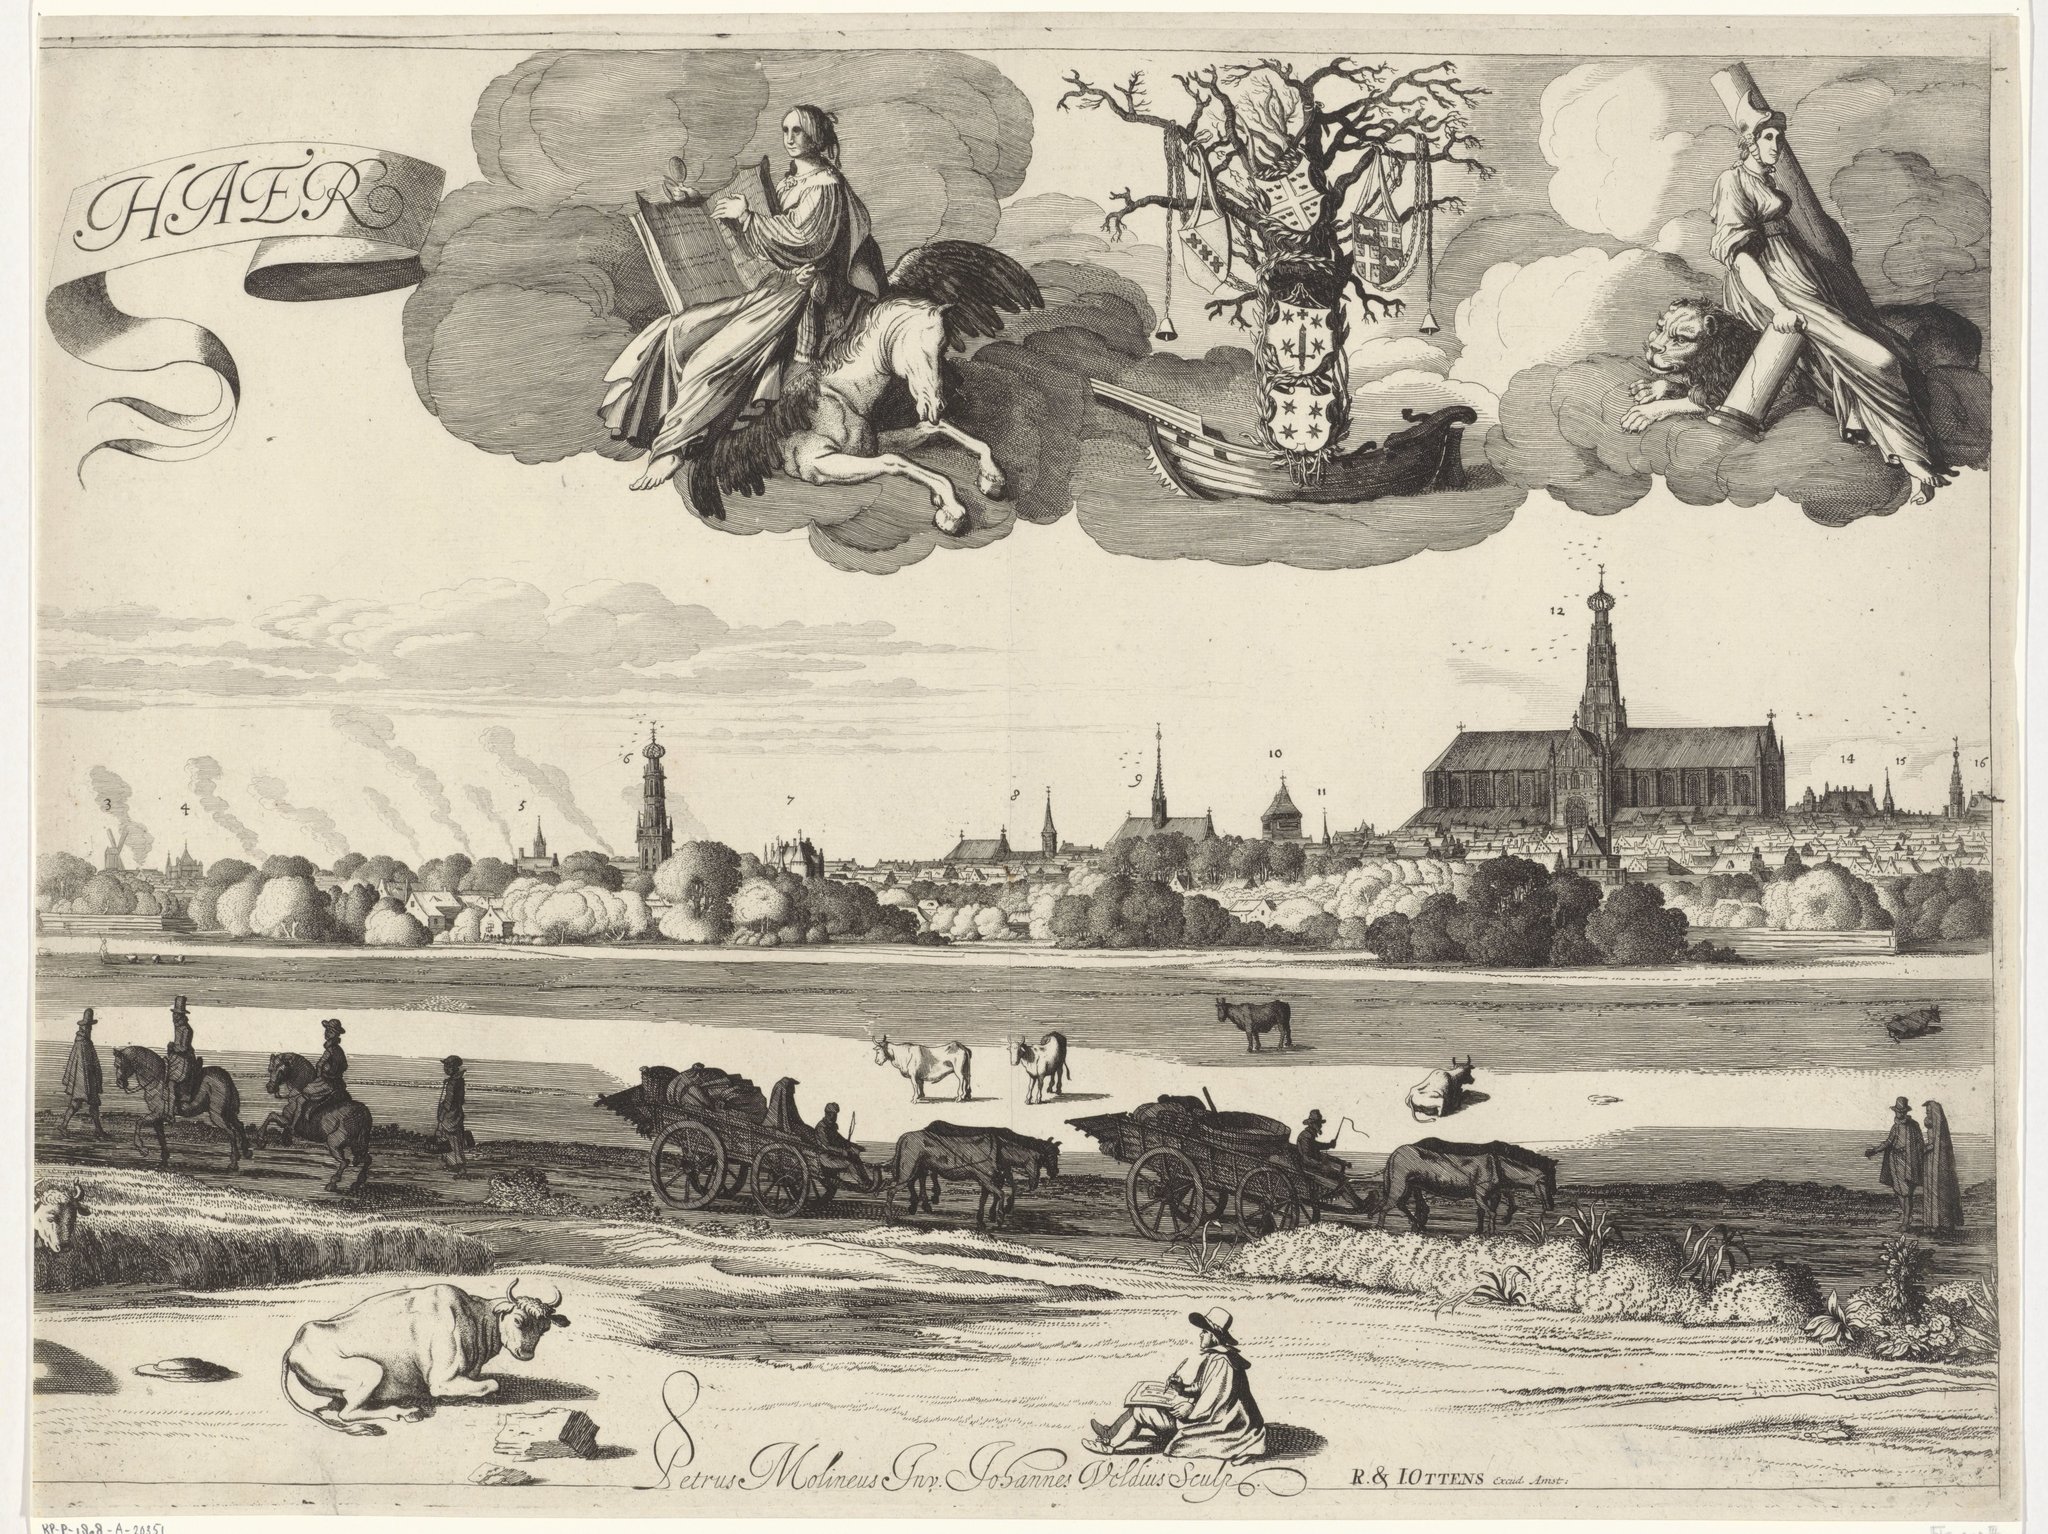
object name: print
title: Haerlem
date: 1621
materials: paper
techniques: etching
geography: amsterdam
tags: fortitude, 'fortitudo' ~ one of the four cardinal virtues, coat of arms (as symbol of the state, etc.), coat of arms (as symbol of the state, etc.) (+ city; municipal), prudence, 'prudentia'; 'prudenza' (ripa) ~ one of the four cardinal virtues, draughtsman at work - cc - out of doors, prospect of city, town panorama, silhouette of city, haarlem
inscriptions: collector's mark: Lugt 964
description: Middelste blad van een gezicht op Haarlem, gezien vanuit het noorden. Boven een wolk met daarin de personificaties van Voorzichtigheid (links) en Kracht (rechts). Tussen de personificaties een dorre boom met daarin vijf wapenschilden, waaronder dat van Haarlem, en twee klokjes (de 'klokjes van Damiate' of 'Damiaatjes'). Onder de boom een boot met een zaag op de boeg. Deze voorstelling verwijst naar de verovering van Damiate. De gebouwen, waaronder de Sint-Bavokerk, zijn voorzien van nummers. Op de voorgrond een tekenaar. Op het tweede plan koetsen, ruiters en wandelaars.